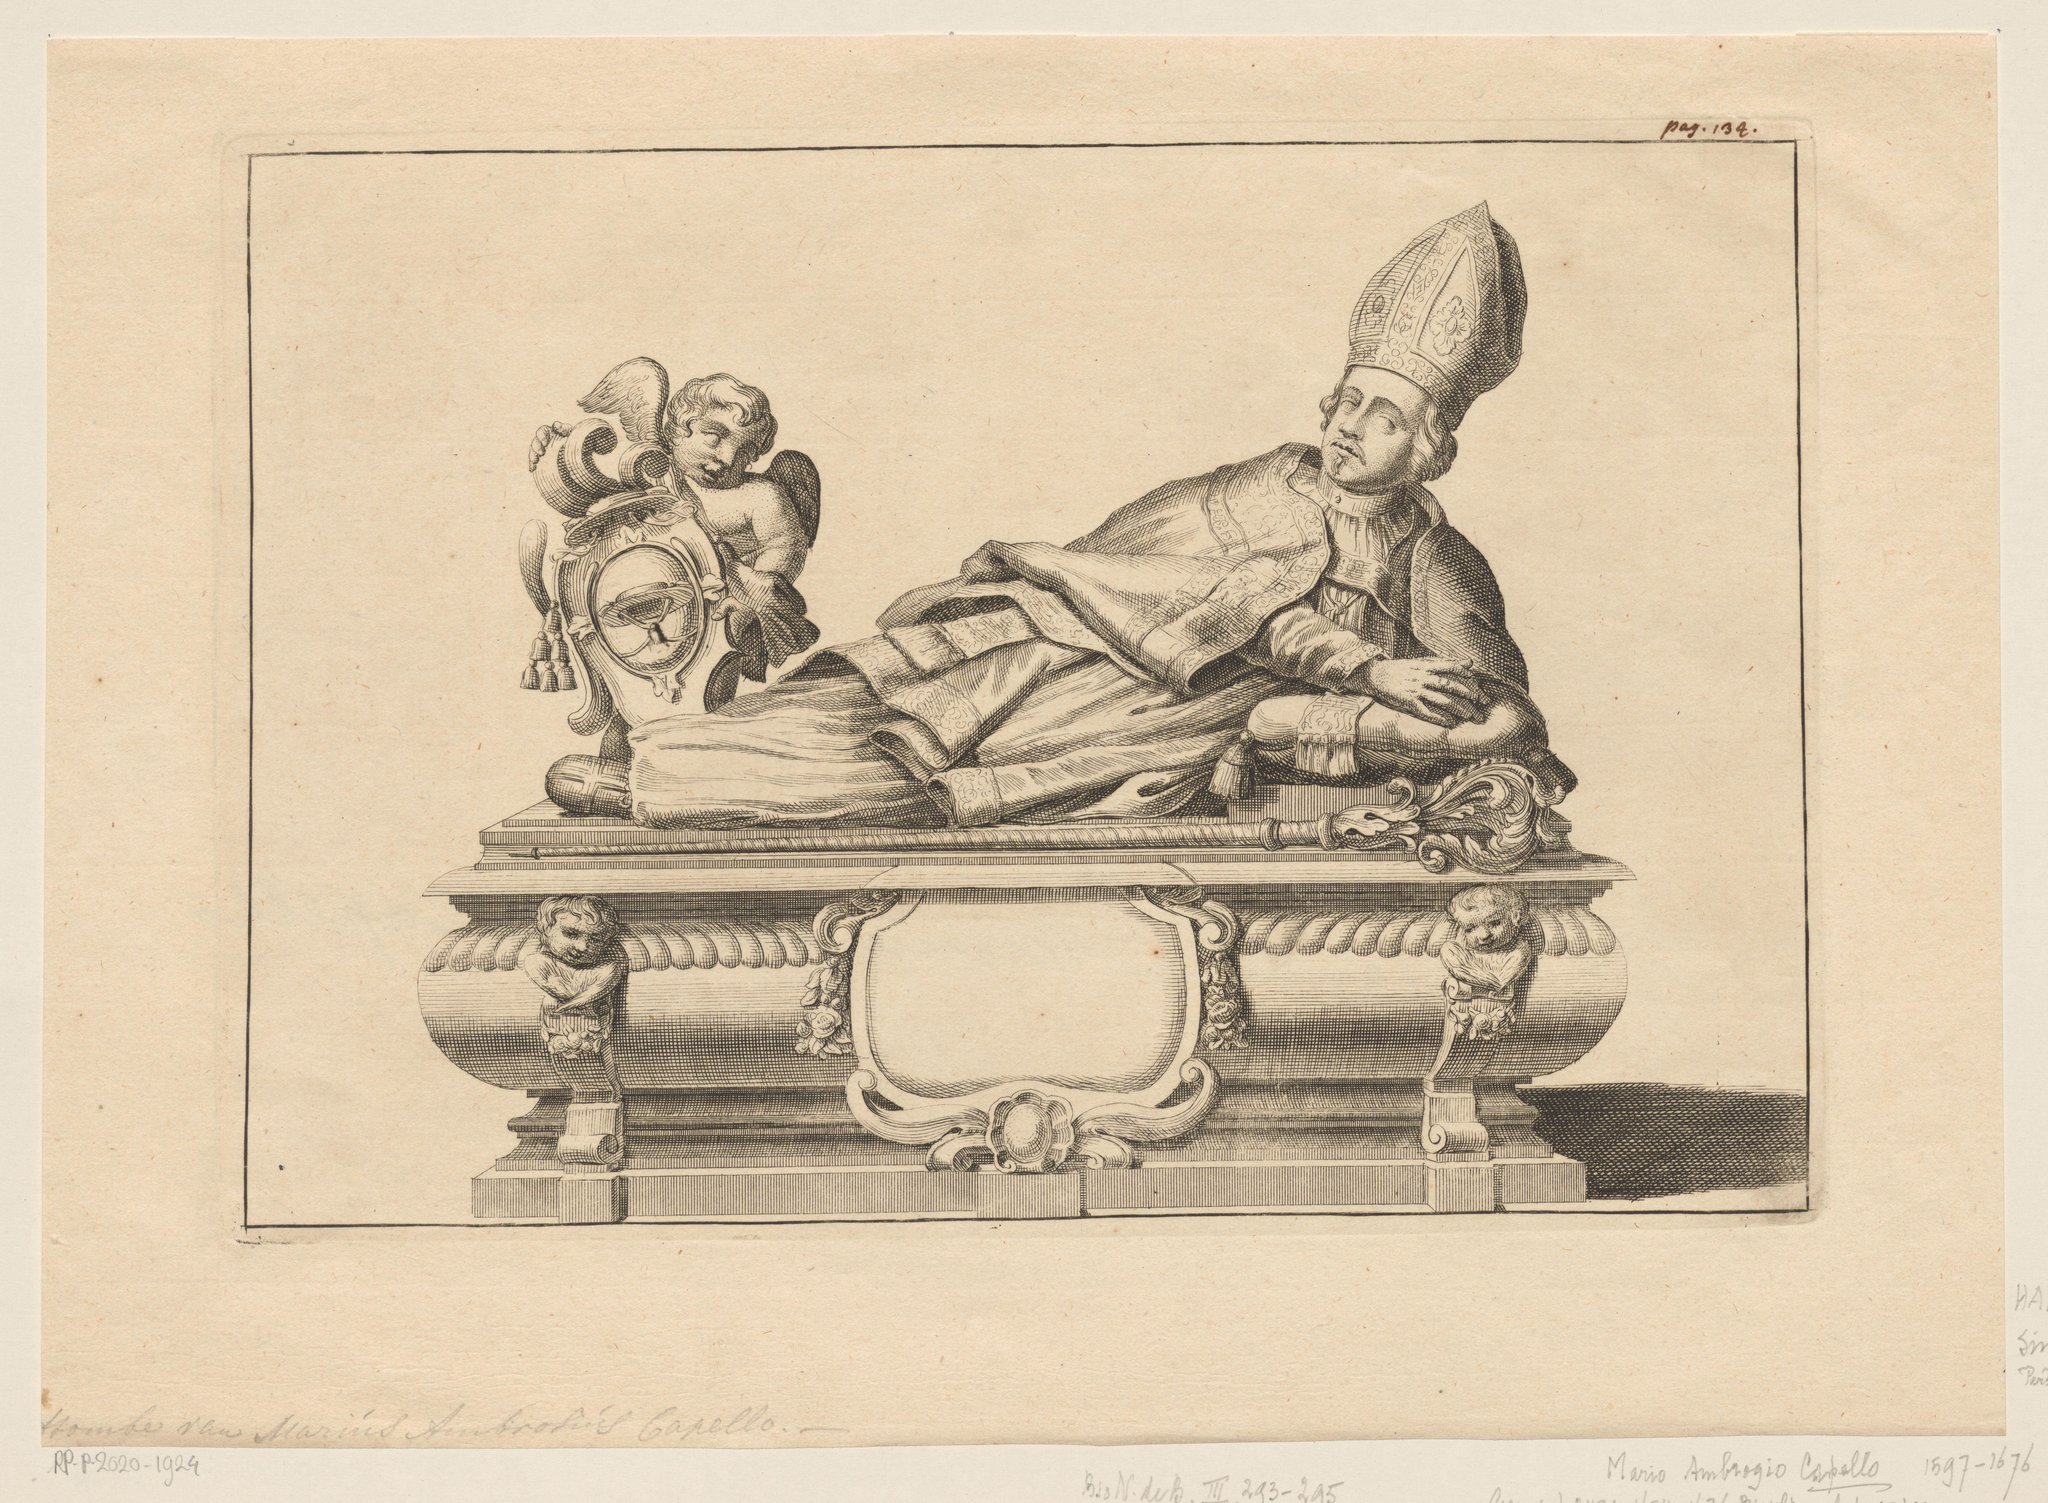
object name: print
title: Grafmonument voor Marius Ambrosius Capello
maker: Anonymous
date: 1676-1749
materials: paper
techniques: etching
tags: antwerp, marius ambrosius capello, historical persons